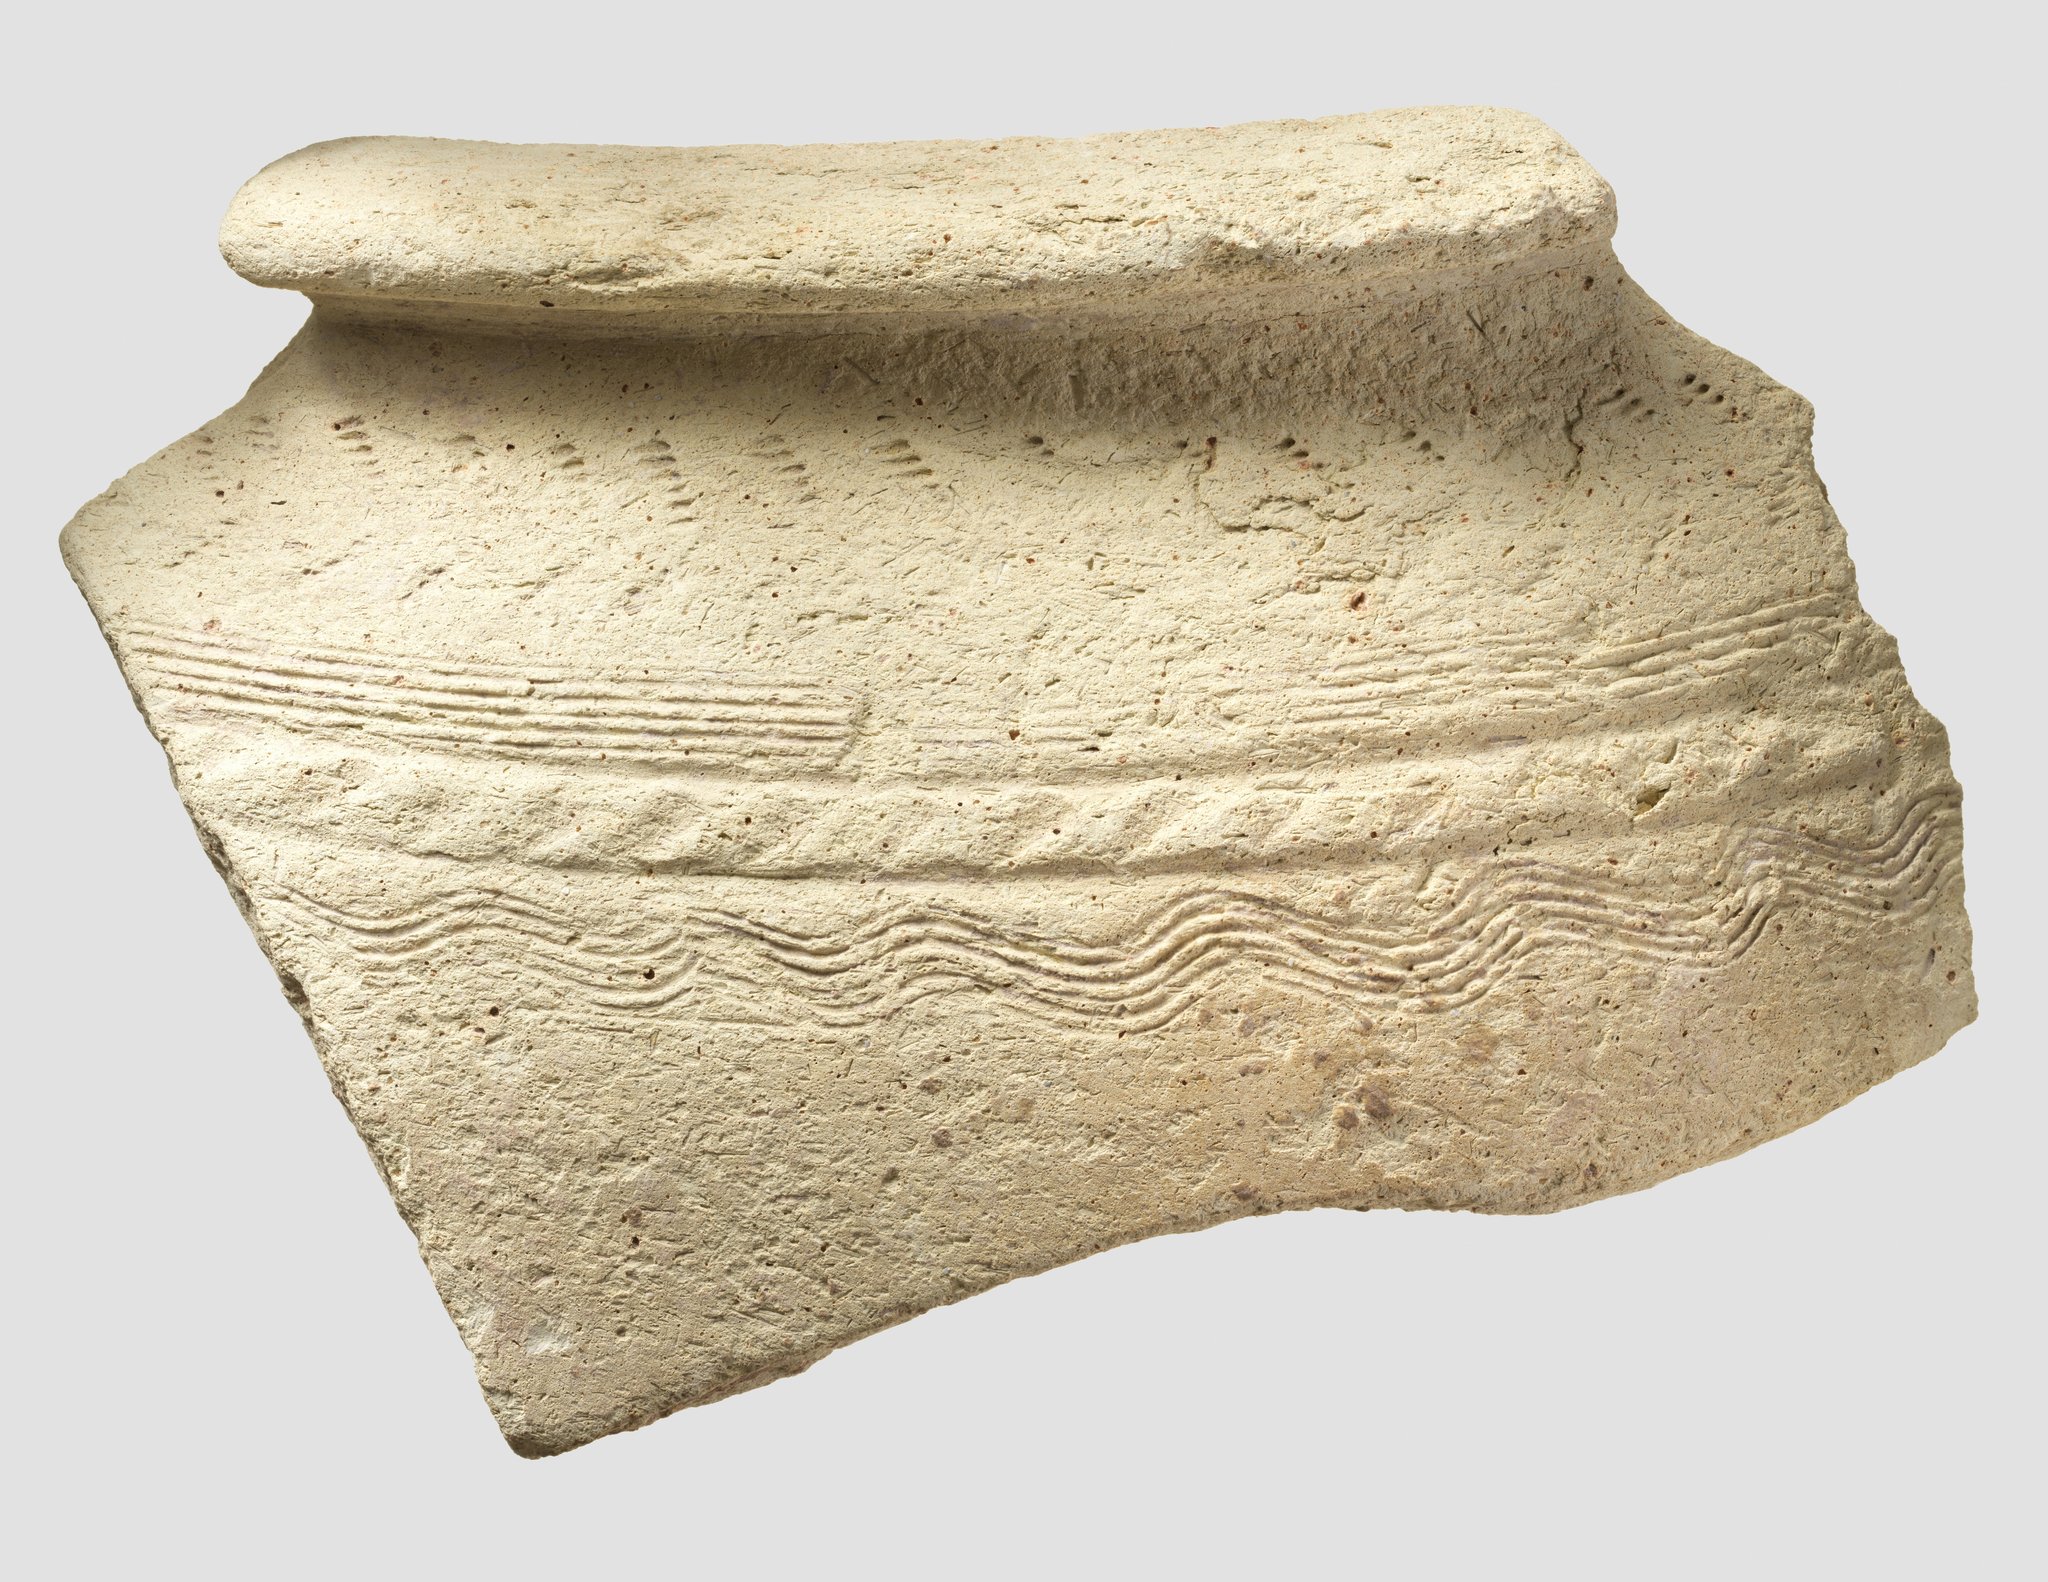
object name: jar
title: Jar rim sherd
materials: ceramic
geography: mesopotamia